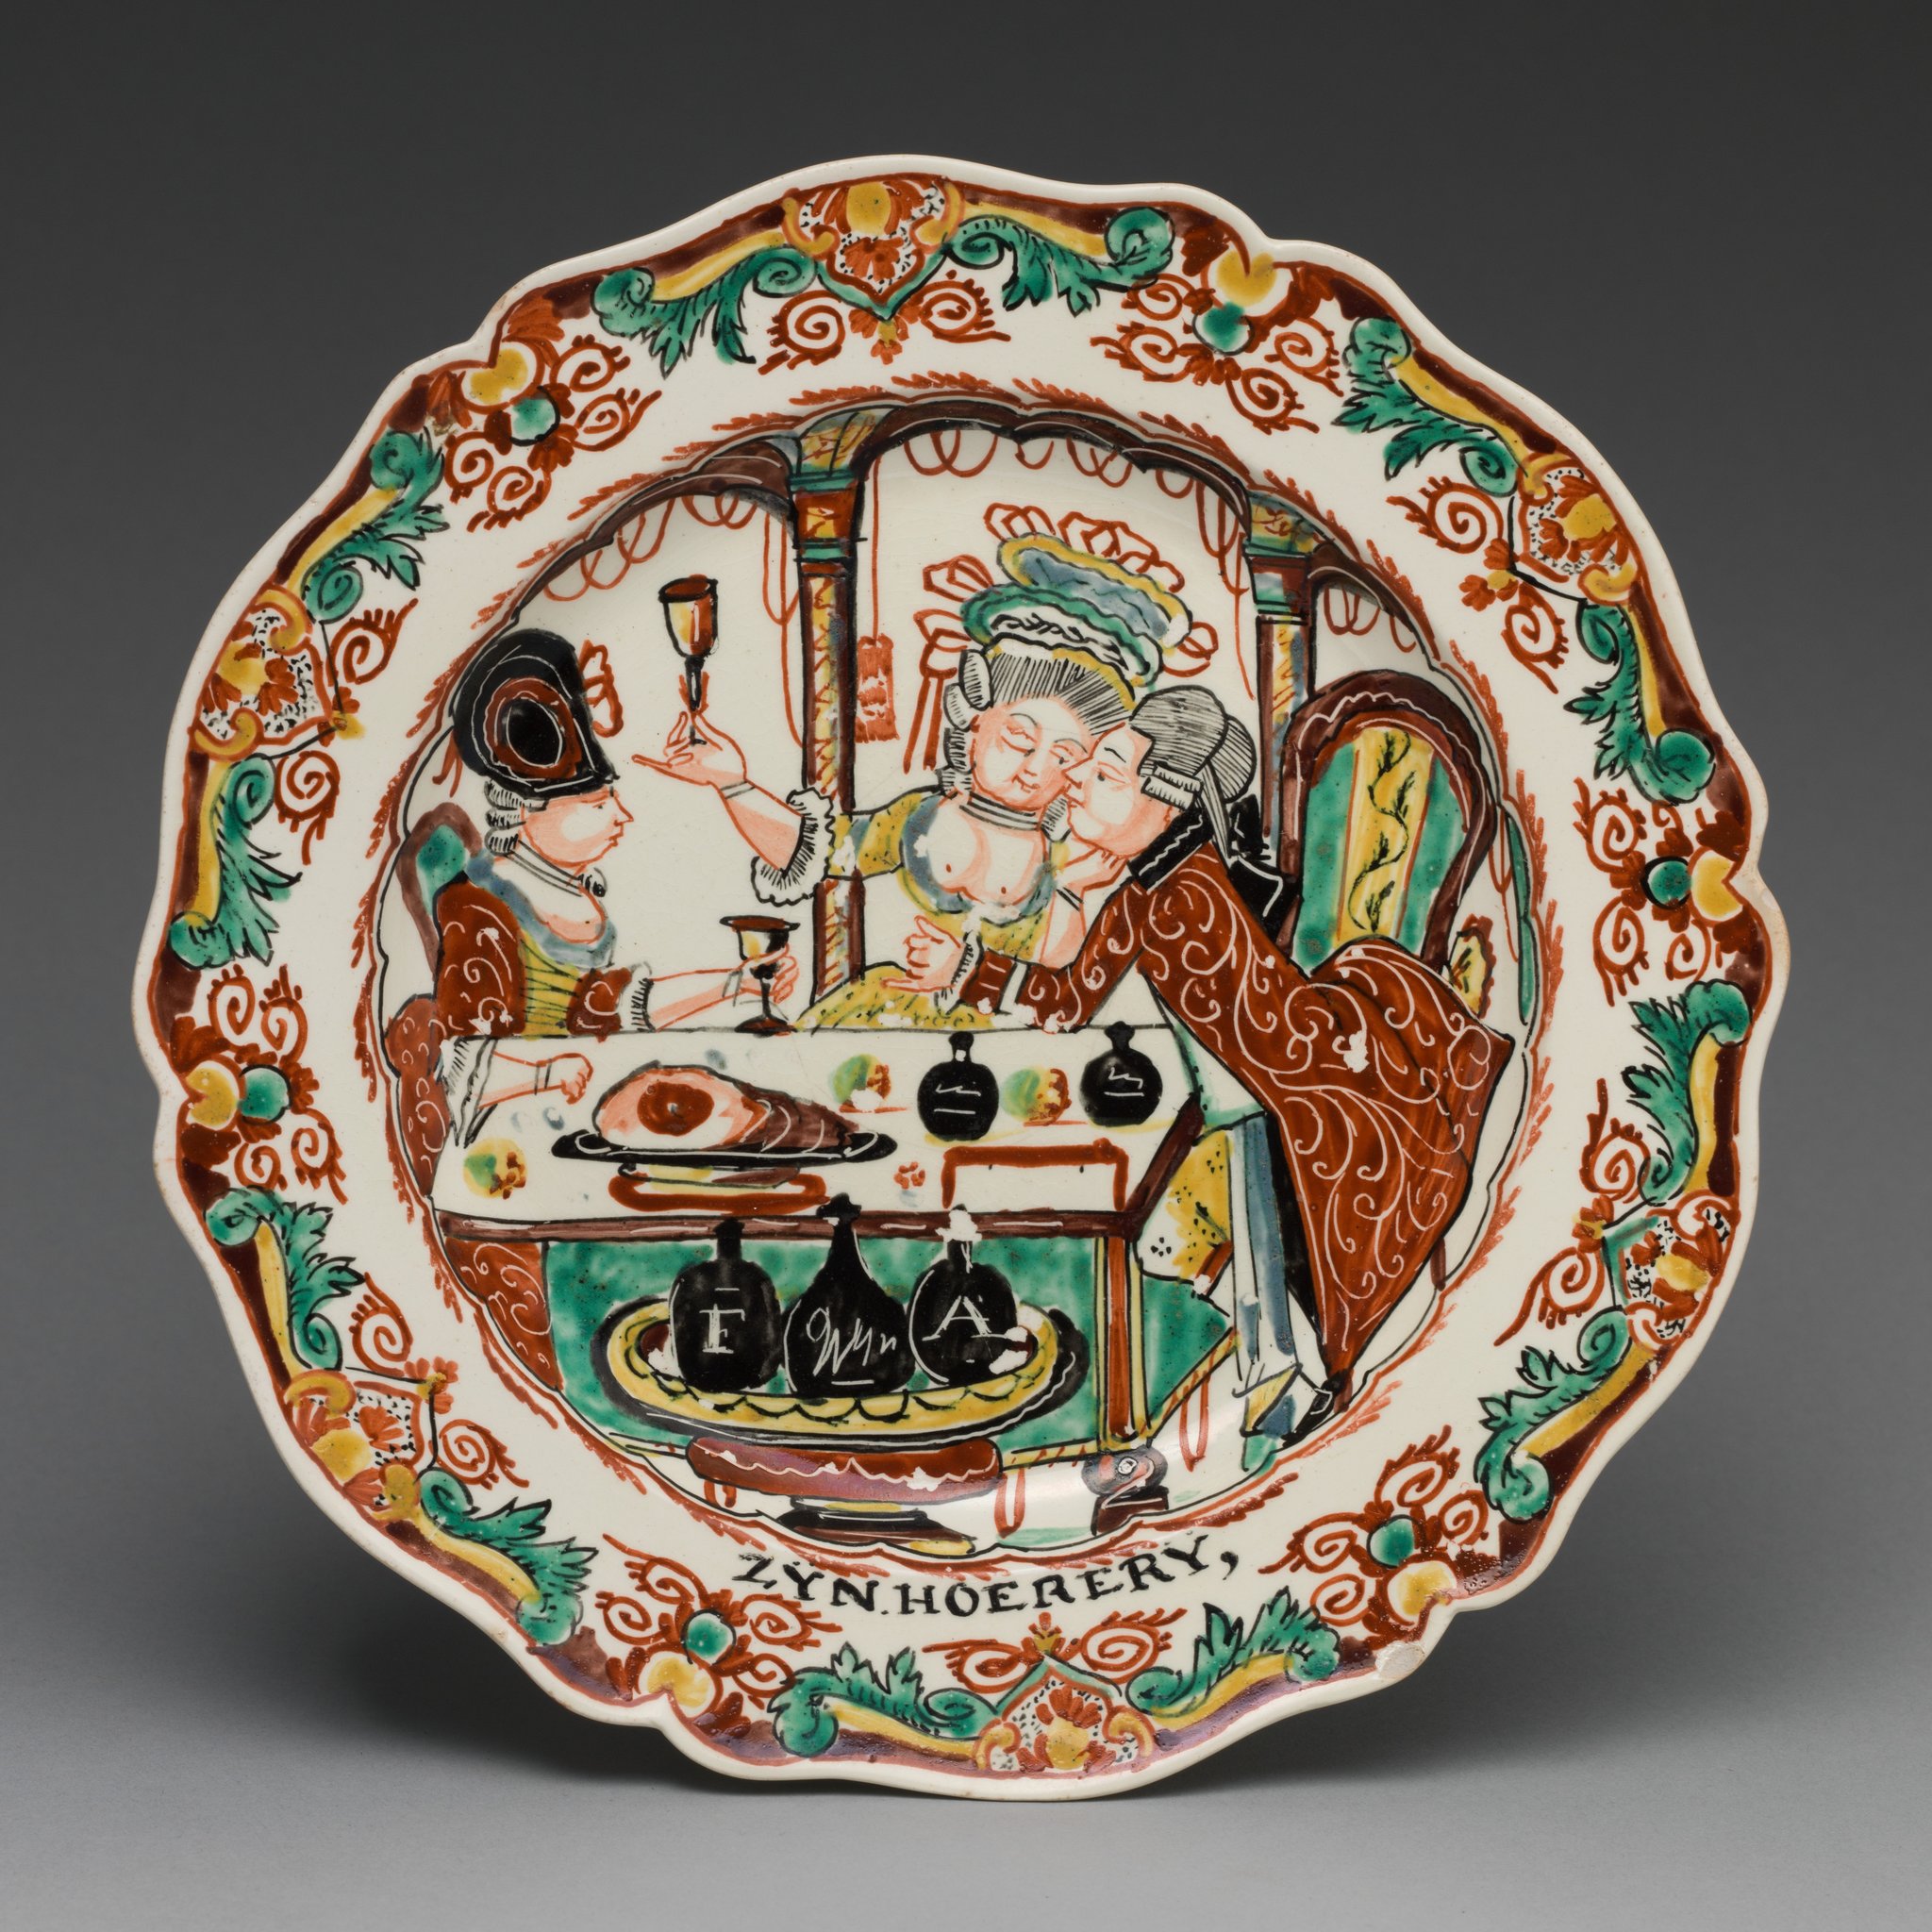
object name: plate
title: Plate (part of a set of six)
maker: john turner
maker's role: maker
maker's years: 1762-1786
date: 1790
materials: earthenware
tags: food,men,women,drinking